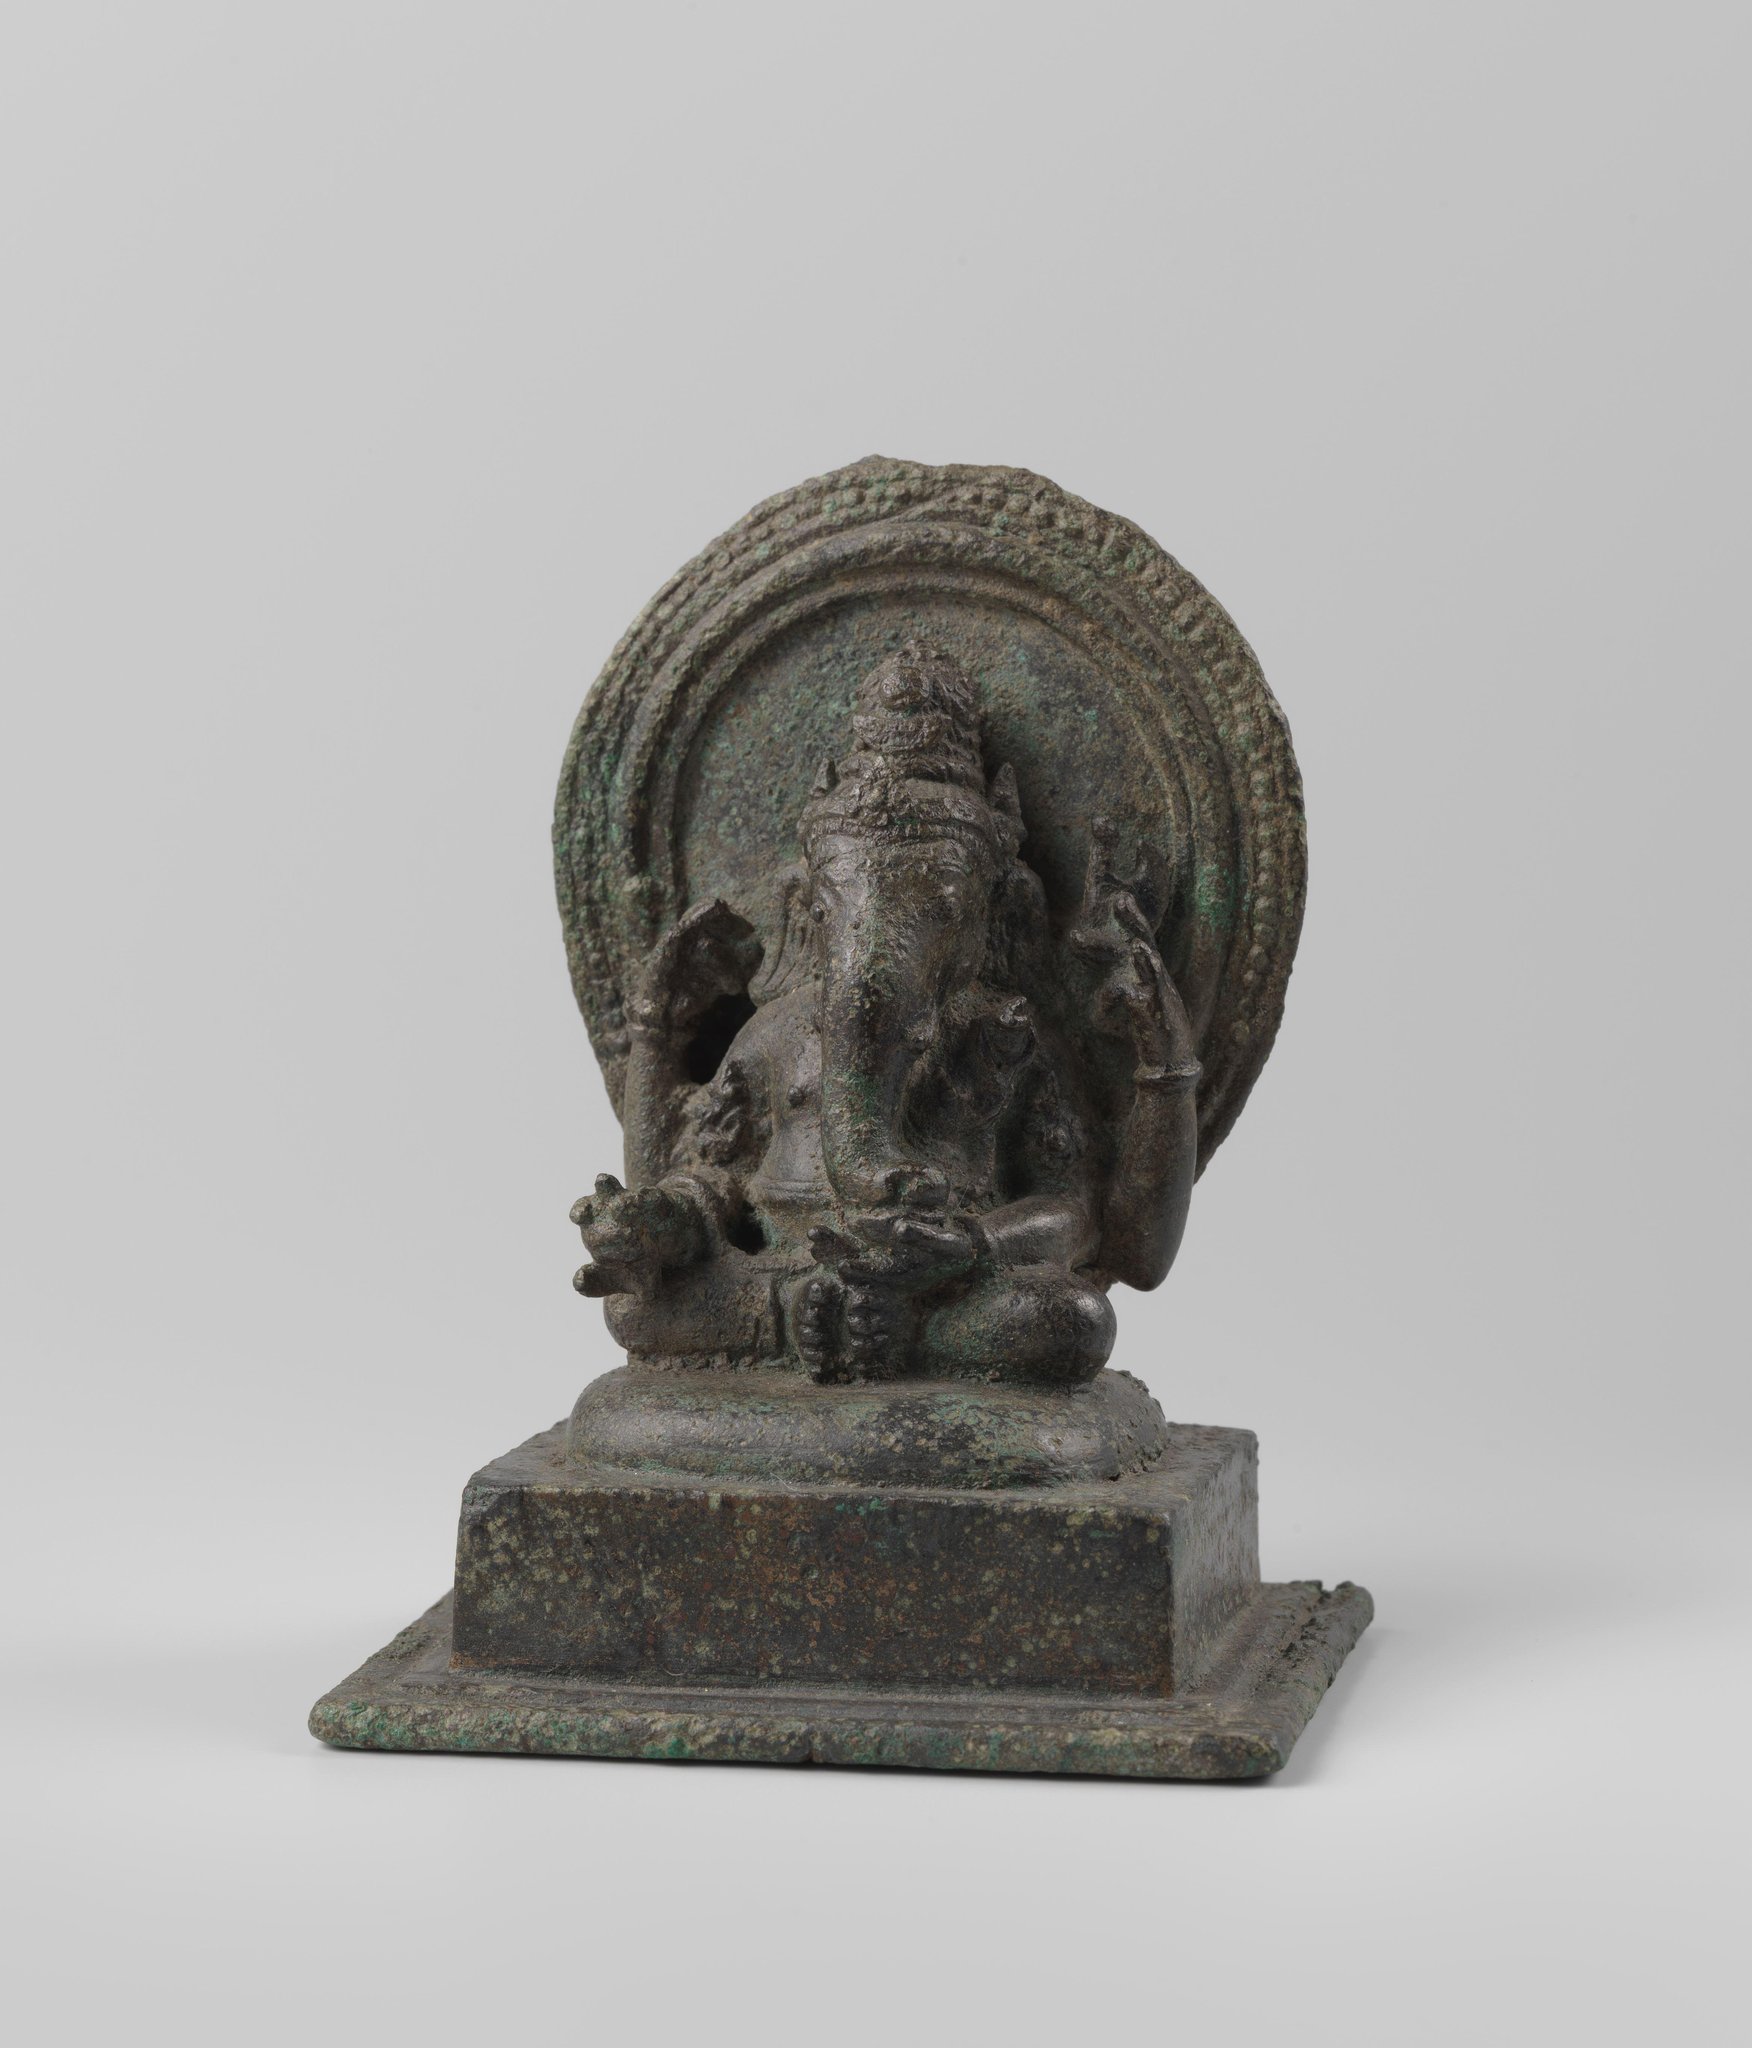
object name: figure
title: Ganesha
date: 800-900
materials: bronze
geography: indonesia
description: Hindu religion and mythology feature elements of the animal world. The Hindu god Shiva is often depicted riding on a bull, but is here shown supported by a seated figure with a bull’s head. Animal strength is also apparent in images of Ganesha, the elephant-headed son of Shiva, who is worshipped as the remover of obstacles.